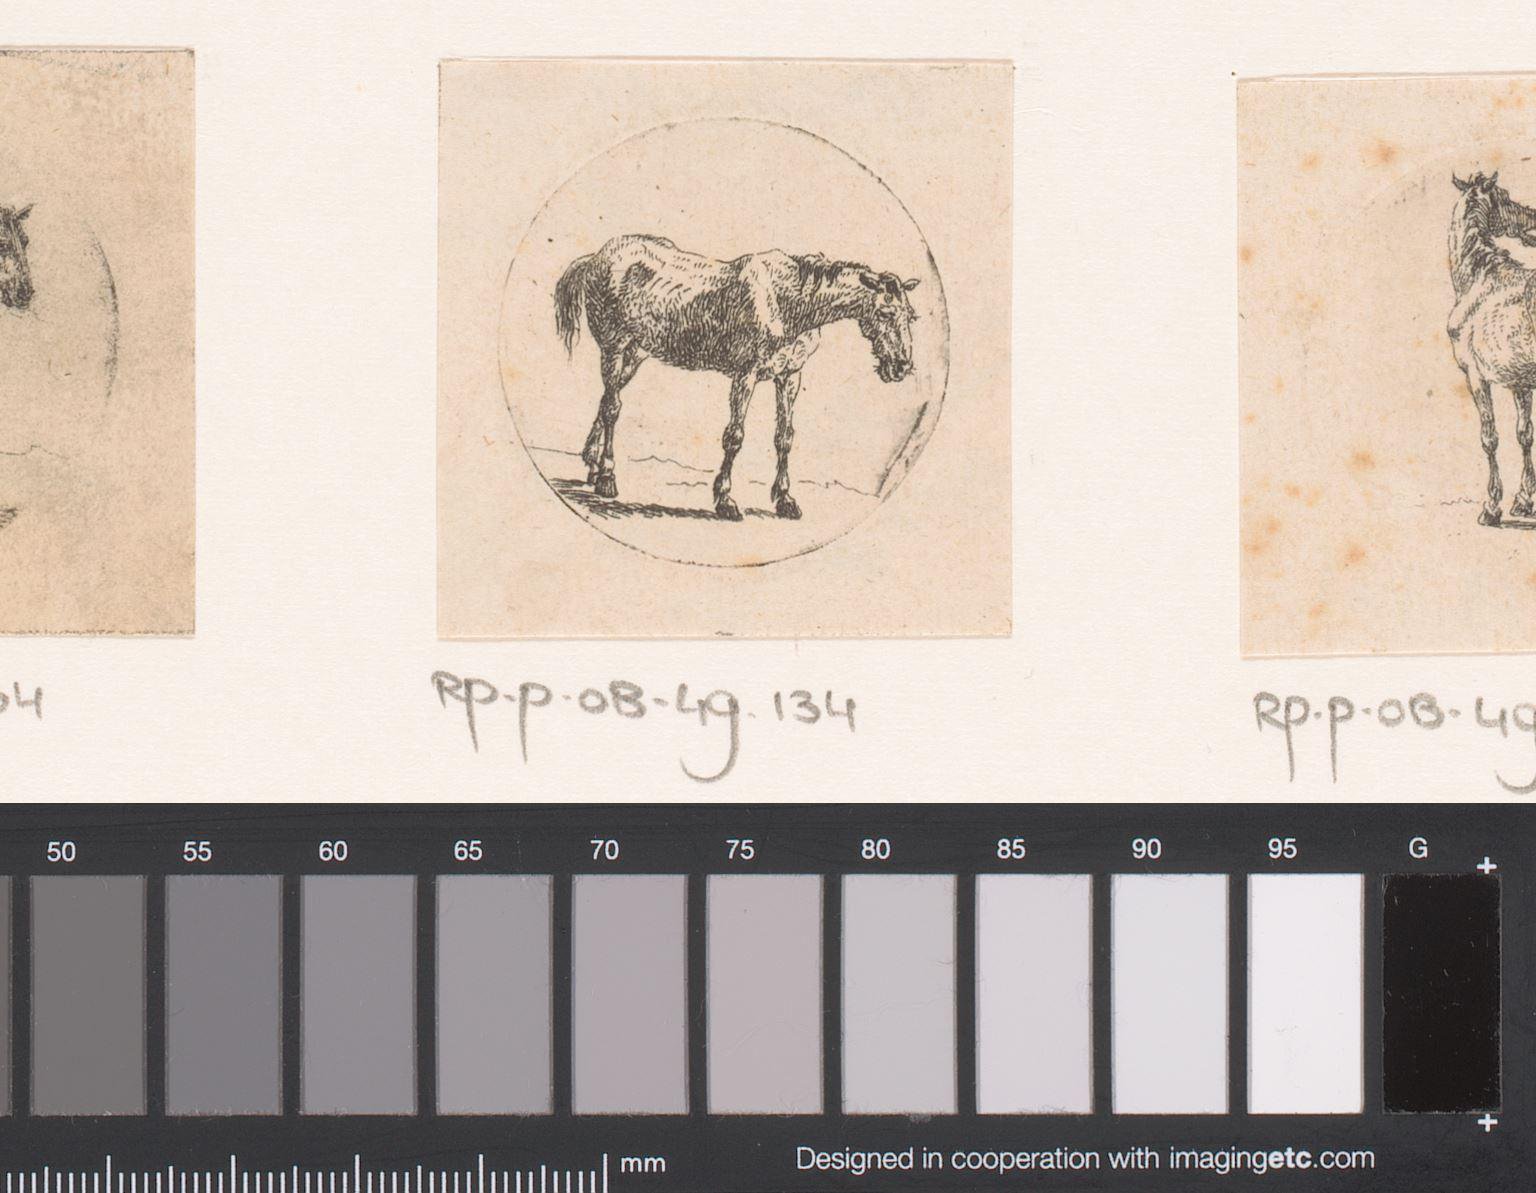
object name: print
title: Staand paard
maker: pierre-françois le roy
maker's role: draughtsman, painter, print maker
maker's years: 1771-1862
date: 1794-1862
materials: paper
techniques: etching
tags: horse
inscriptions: collector's mark: Lugt 2228